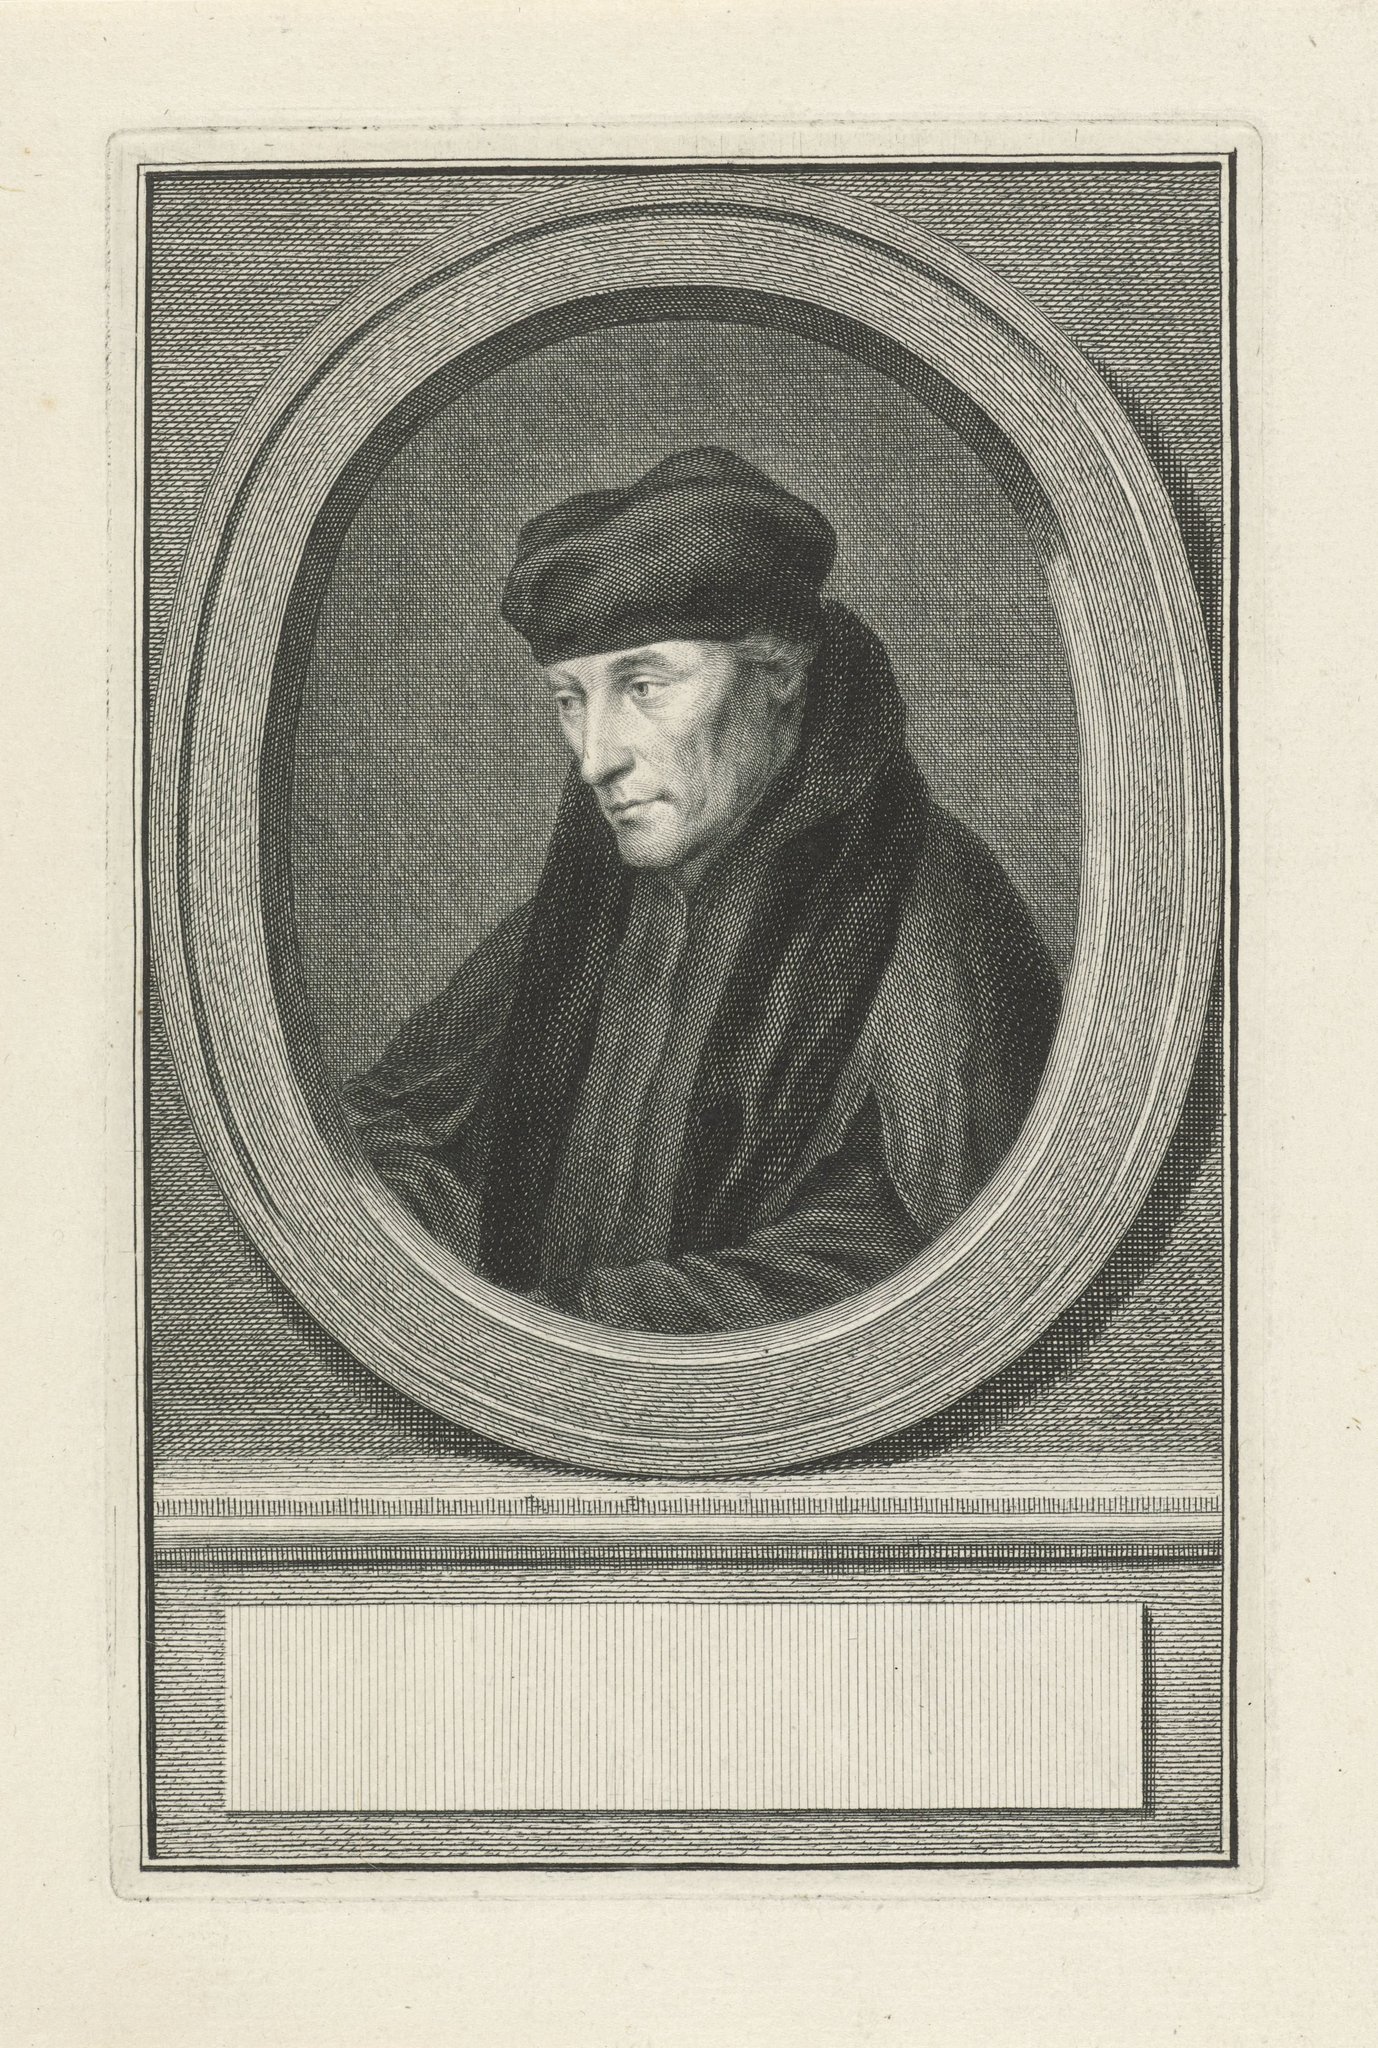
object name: print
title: Portret van Desiderius Erasmus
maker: jacob houbraken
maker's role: draughtsman, print maker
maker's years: 1698-1780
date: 1747-1759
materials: paper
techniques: engraving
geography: amsterdam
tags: rotterdam, desiderius erasmus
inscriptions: collector's mark: Lugt 240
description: Proefdruk van de prent gebruikt in: Jan Wagenaar, Vaderlandsche historie, vervattende de geschiedenissen der nu Vereenigde Nederlanden, inzonderheid die van Holland (...), 21 delen. Amsterdam, Isaak Tirion, 1749-59.